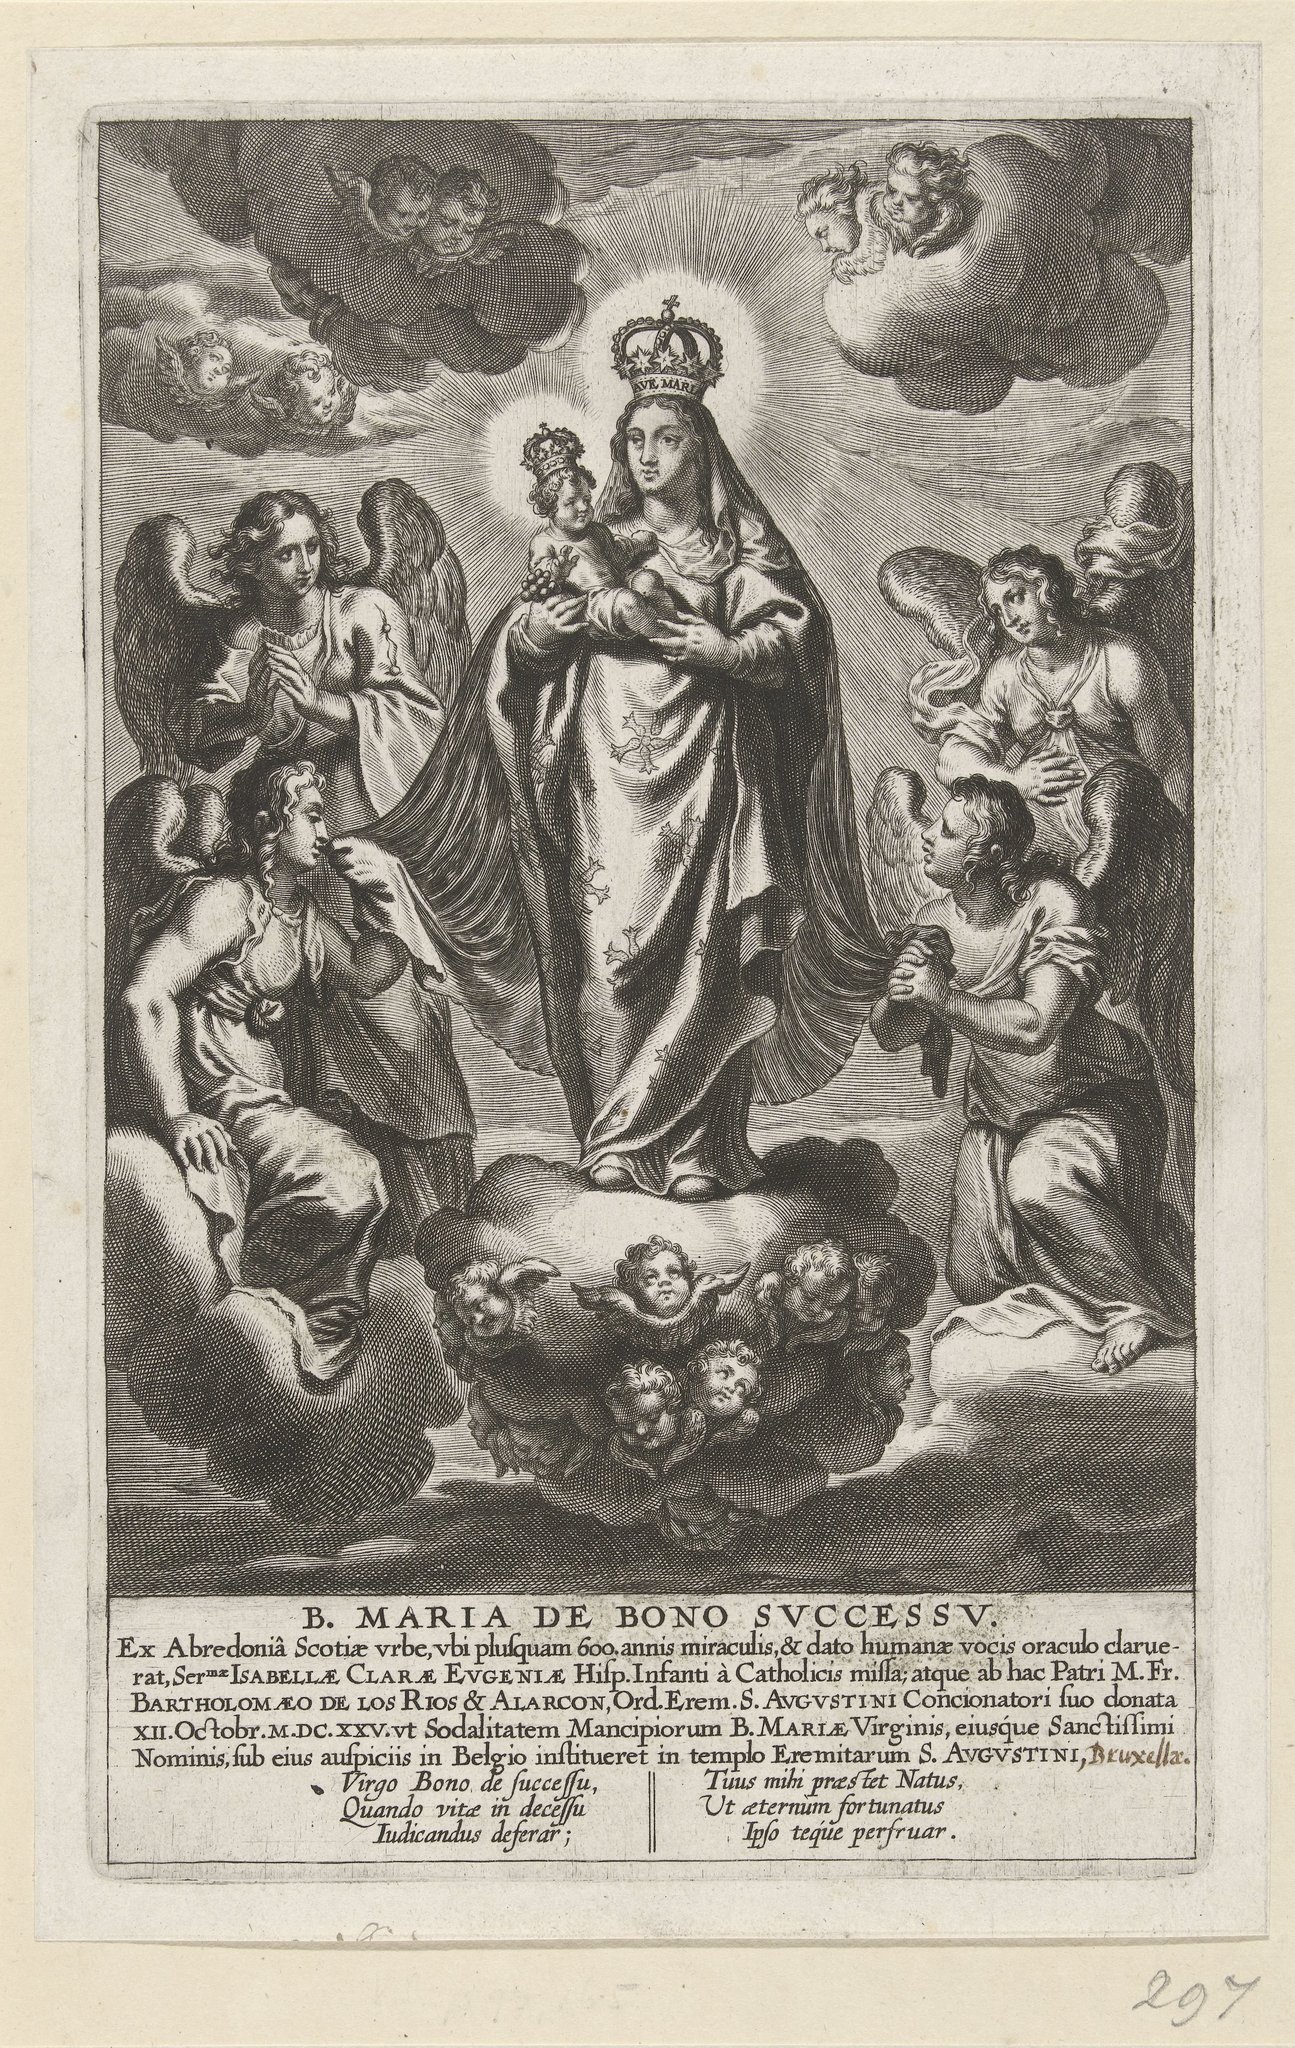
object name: print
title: Maria met Kind op een wolk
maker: cornelis galle (i)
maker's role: print maker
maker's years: 1576-1650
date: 1586-1650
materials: paper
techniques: engraving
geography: southern netherlands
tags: specific types of standing (or half-length) madonna's, without others (+ angel(s))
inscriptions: collector's mark: Lugt 240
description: Gekroonde Maria met Kind staand op een wolk met cherubijnen. Aan weerszijden vier engelen. Onder de voorstelling een Latijnse tekst en een vers in twee coupletten. In de tekst wordt verwezen naar de St. Augustinuskerk in Brussel.